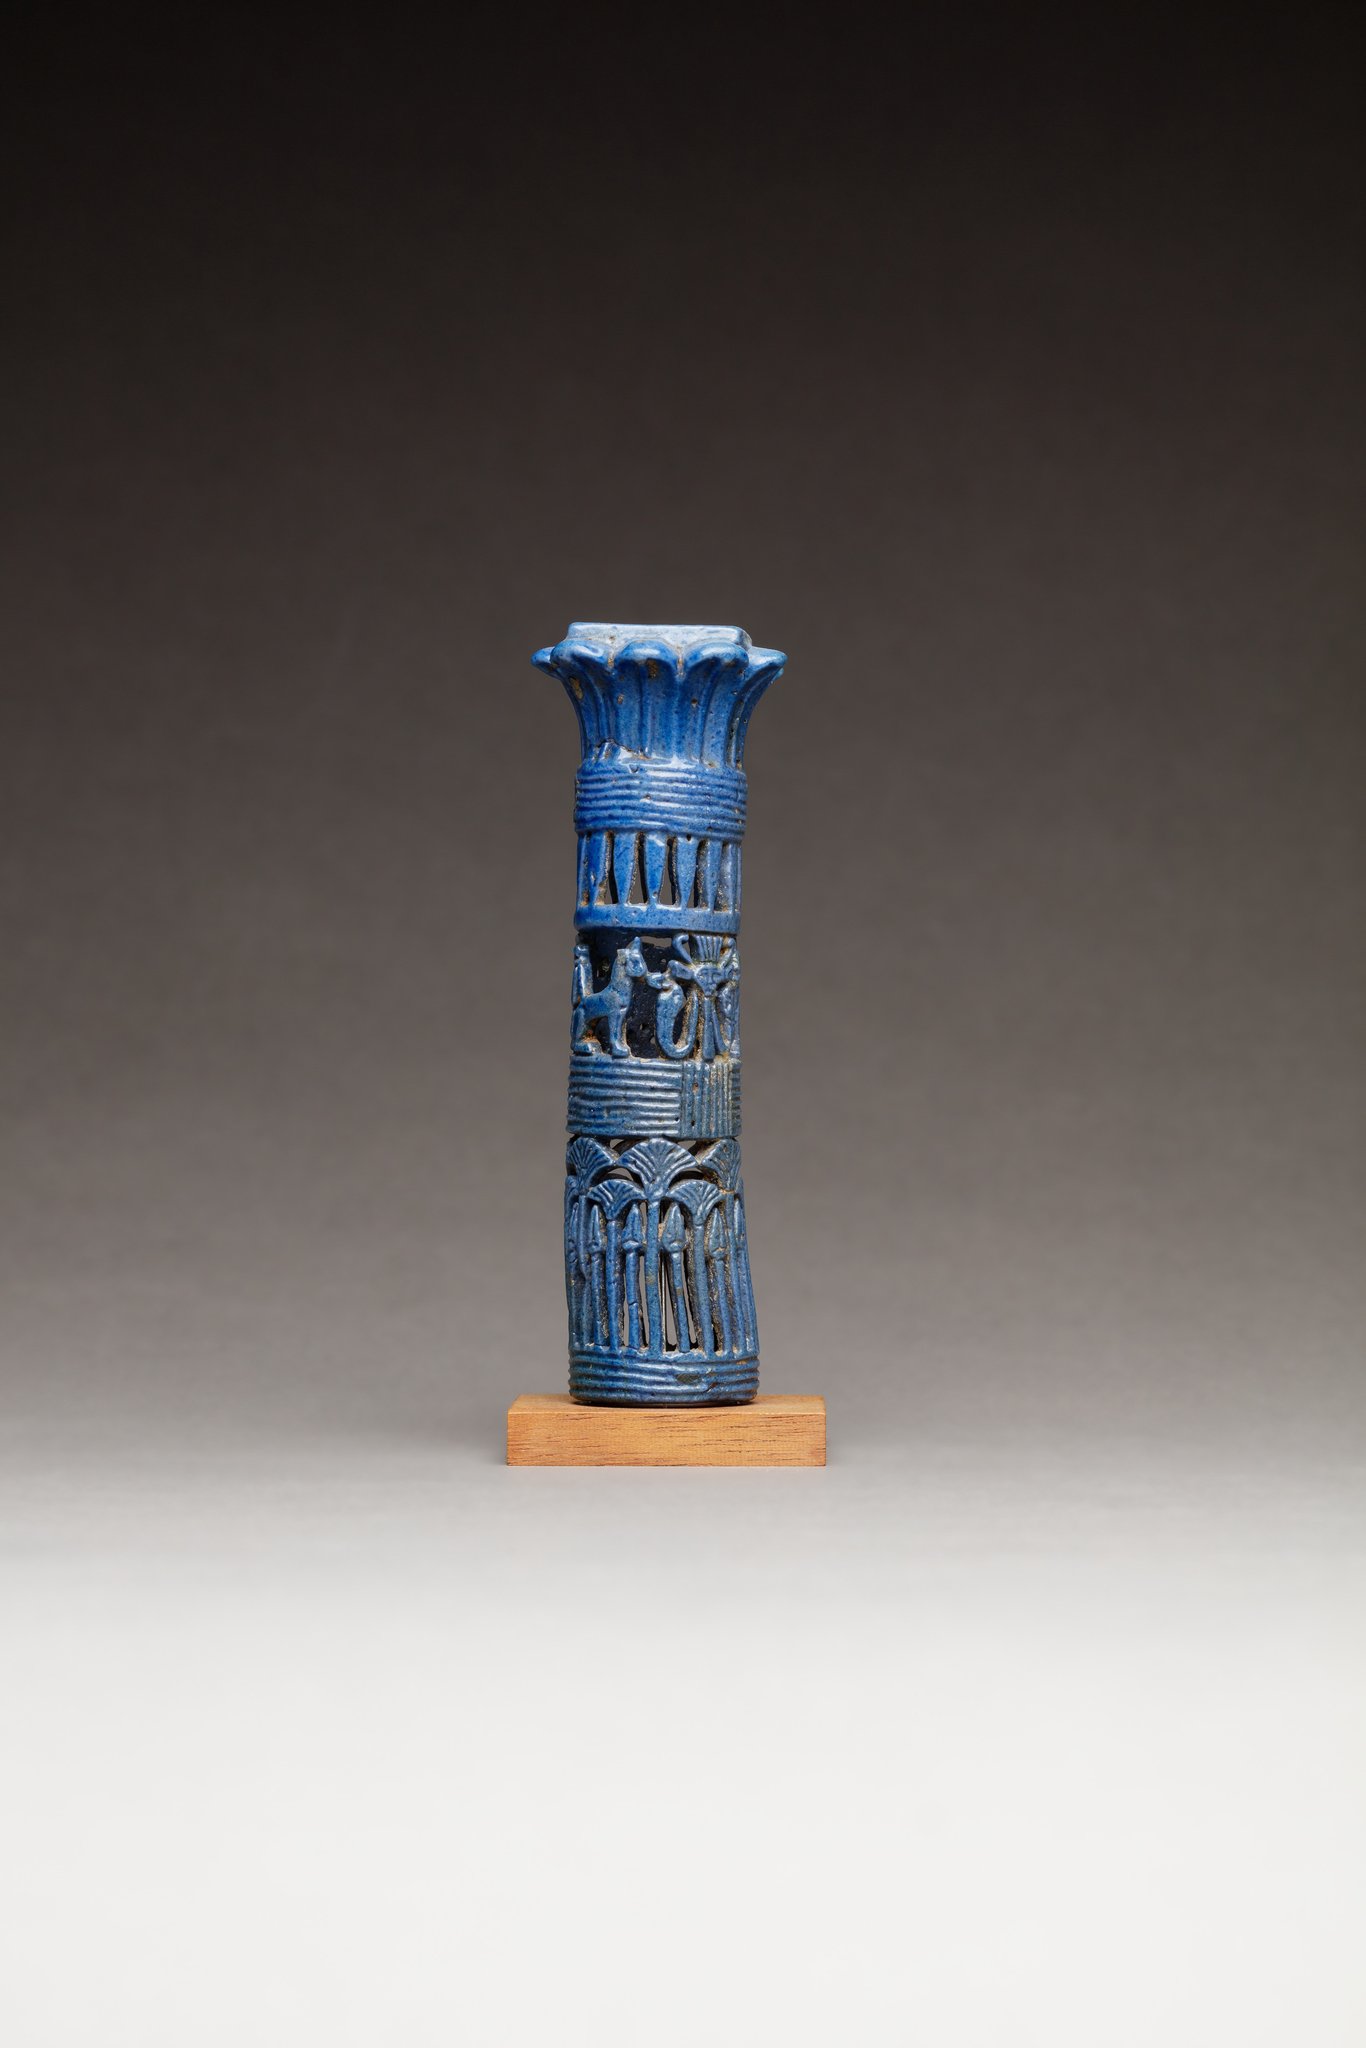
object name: kohl tube, papyrus column, openwork. hathor, cat, taweret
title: Kohl Tube Holder in the Form of a Papyrus Column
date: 1390-1352 BCE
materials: faience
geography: egypt